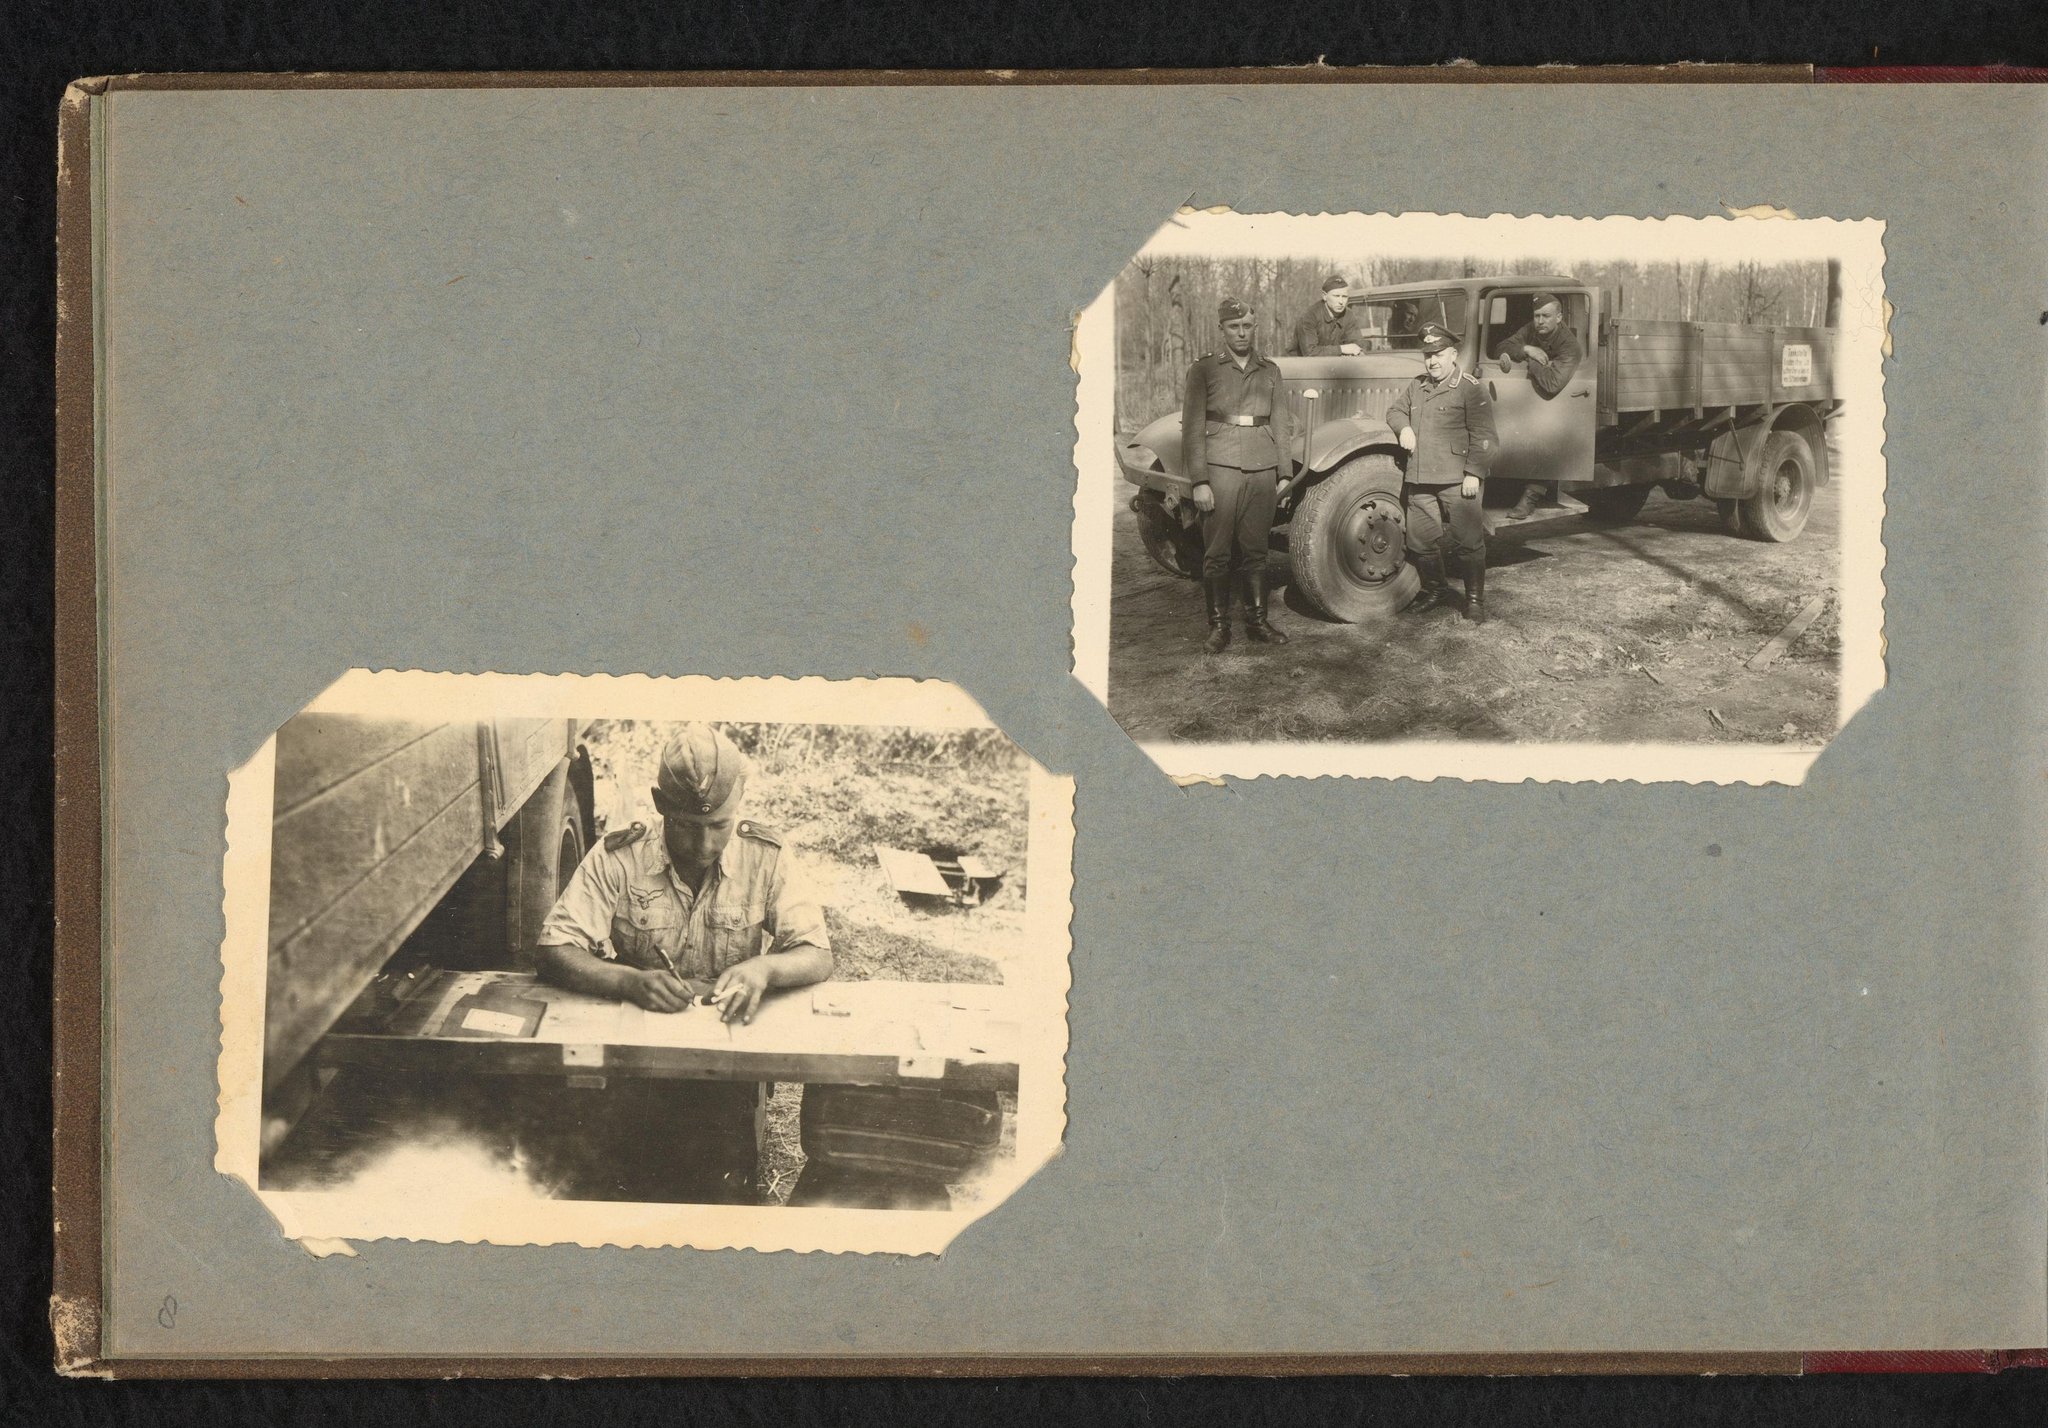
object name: photograph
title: Vrachtauto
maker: Anonymous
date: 1940-1945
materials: paper, photographic support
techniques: gelatin silver print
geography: germany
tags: modern forms of military vehicles, germany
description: Albumblad met twee foto's van Duitse militairen in en om een vrachtauto. Onderdeel van een fotoalbum over de diensttijd van Dieter Glitsch uit Hardegsen tijdens de Tweede Wereldoorlog en de jaren daarna.